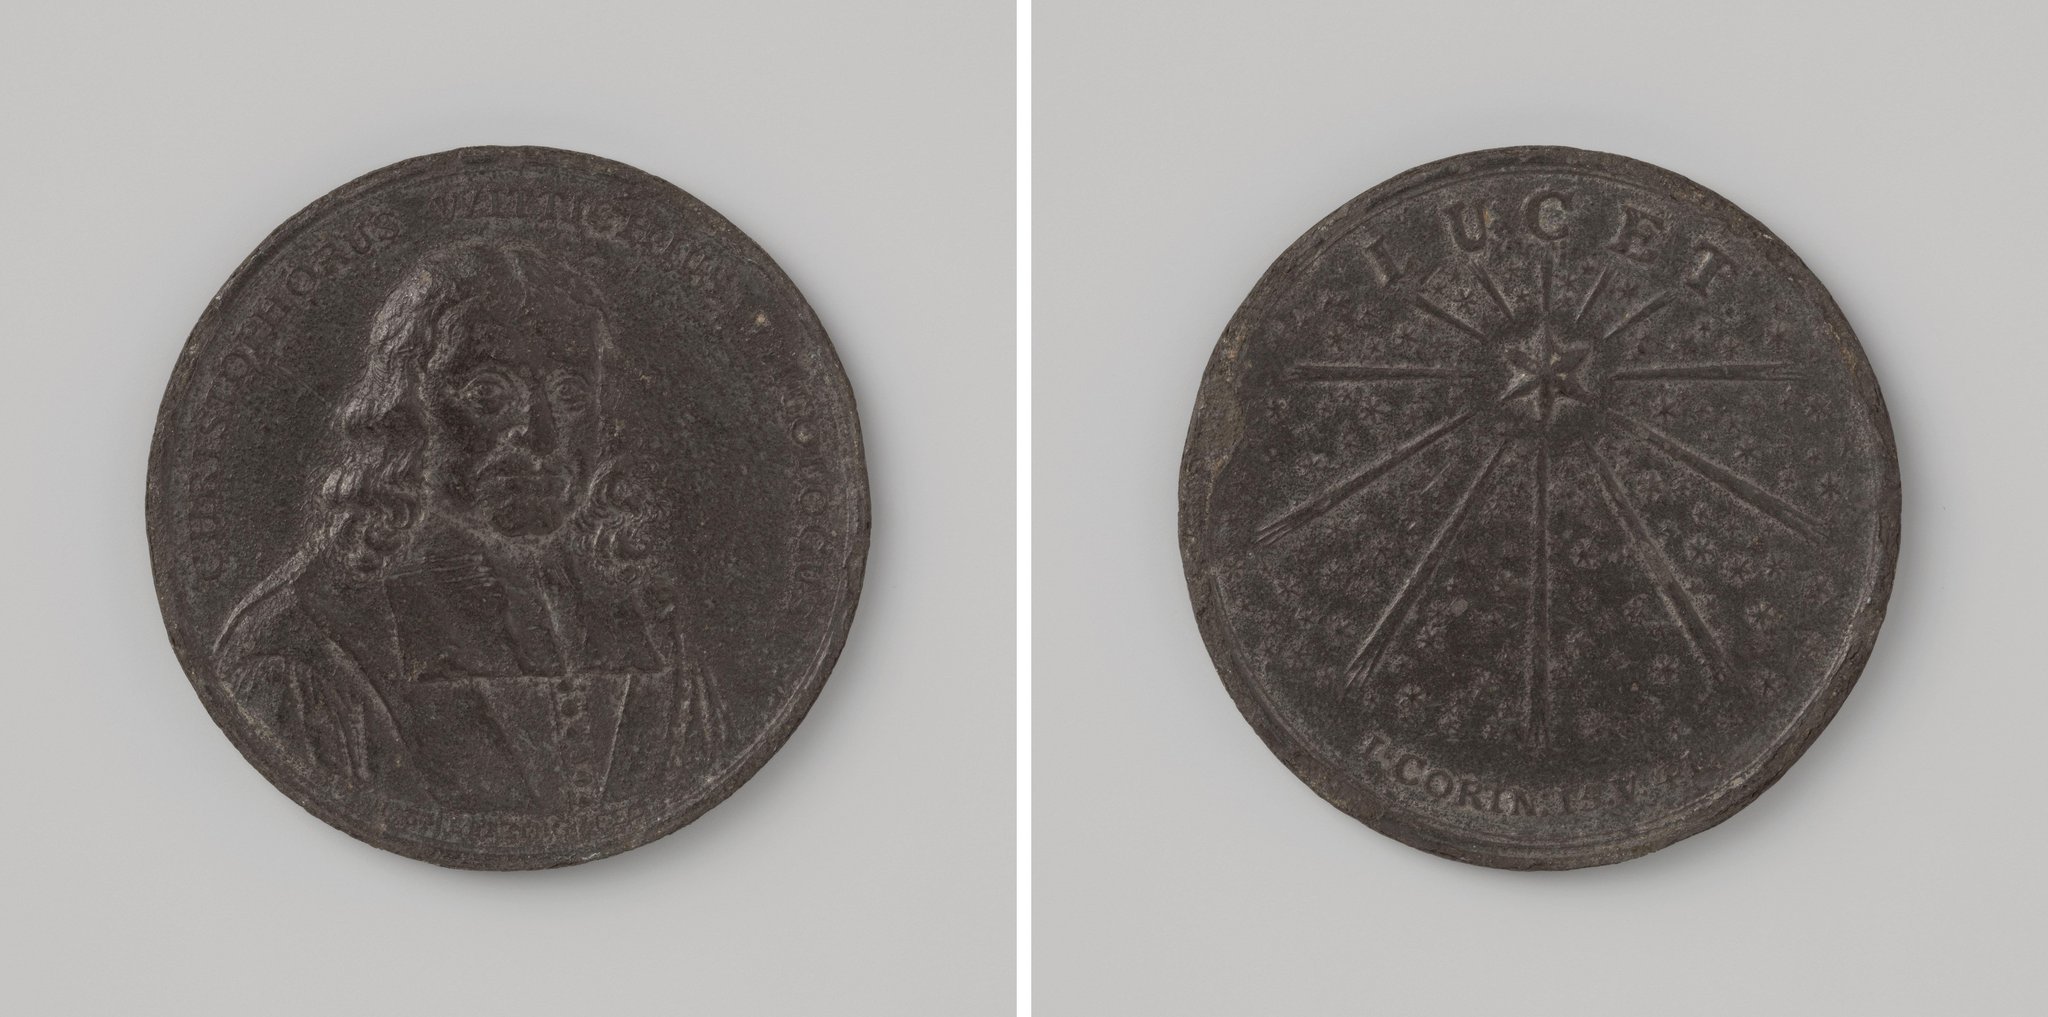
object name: history medal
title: Overlijden van Christoph Wittich, Nederlands theoloog, 1687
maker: smelting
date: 1687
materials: tin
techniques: casting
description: Tinnen penning, op de voorzijde het borstbeeld van Wittich half naar rechts met omschrift, op de keerzijde één stralende ster midden van vele, met omschrift.